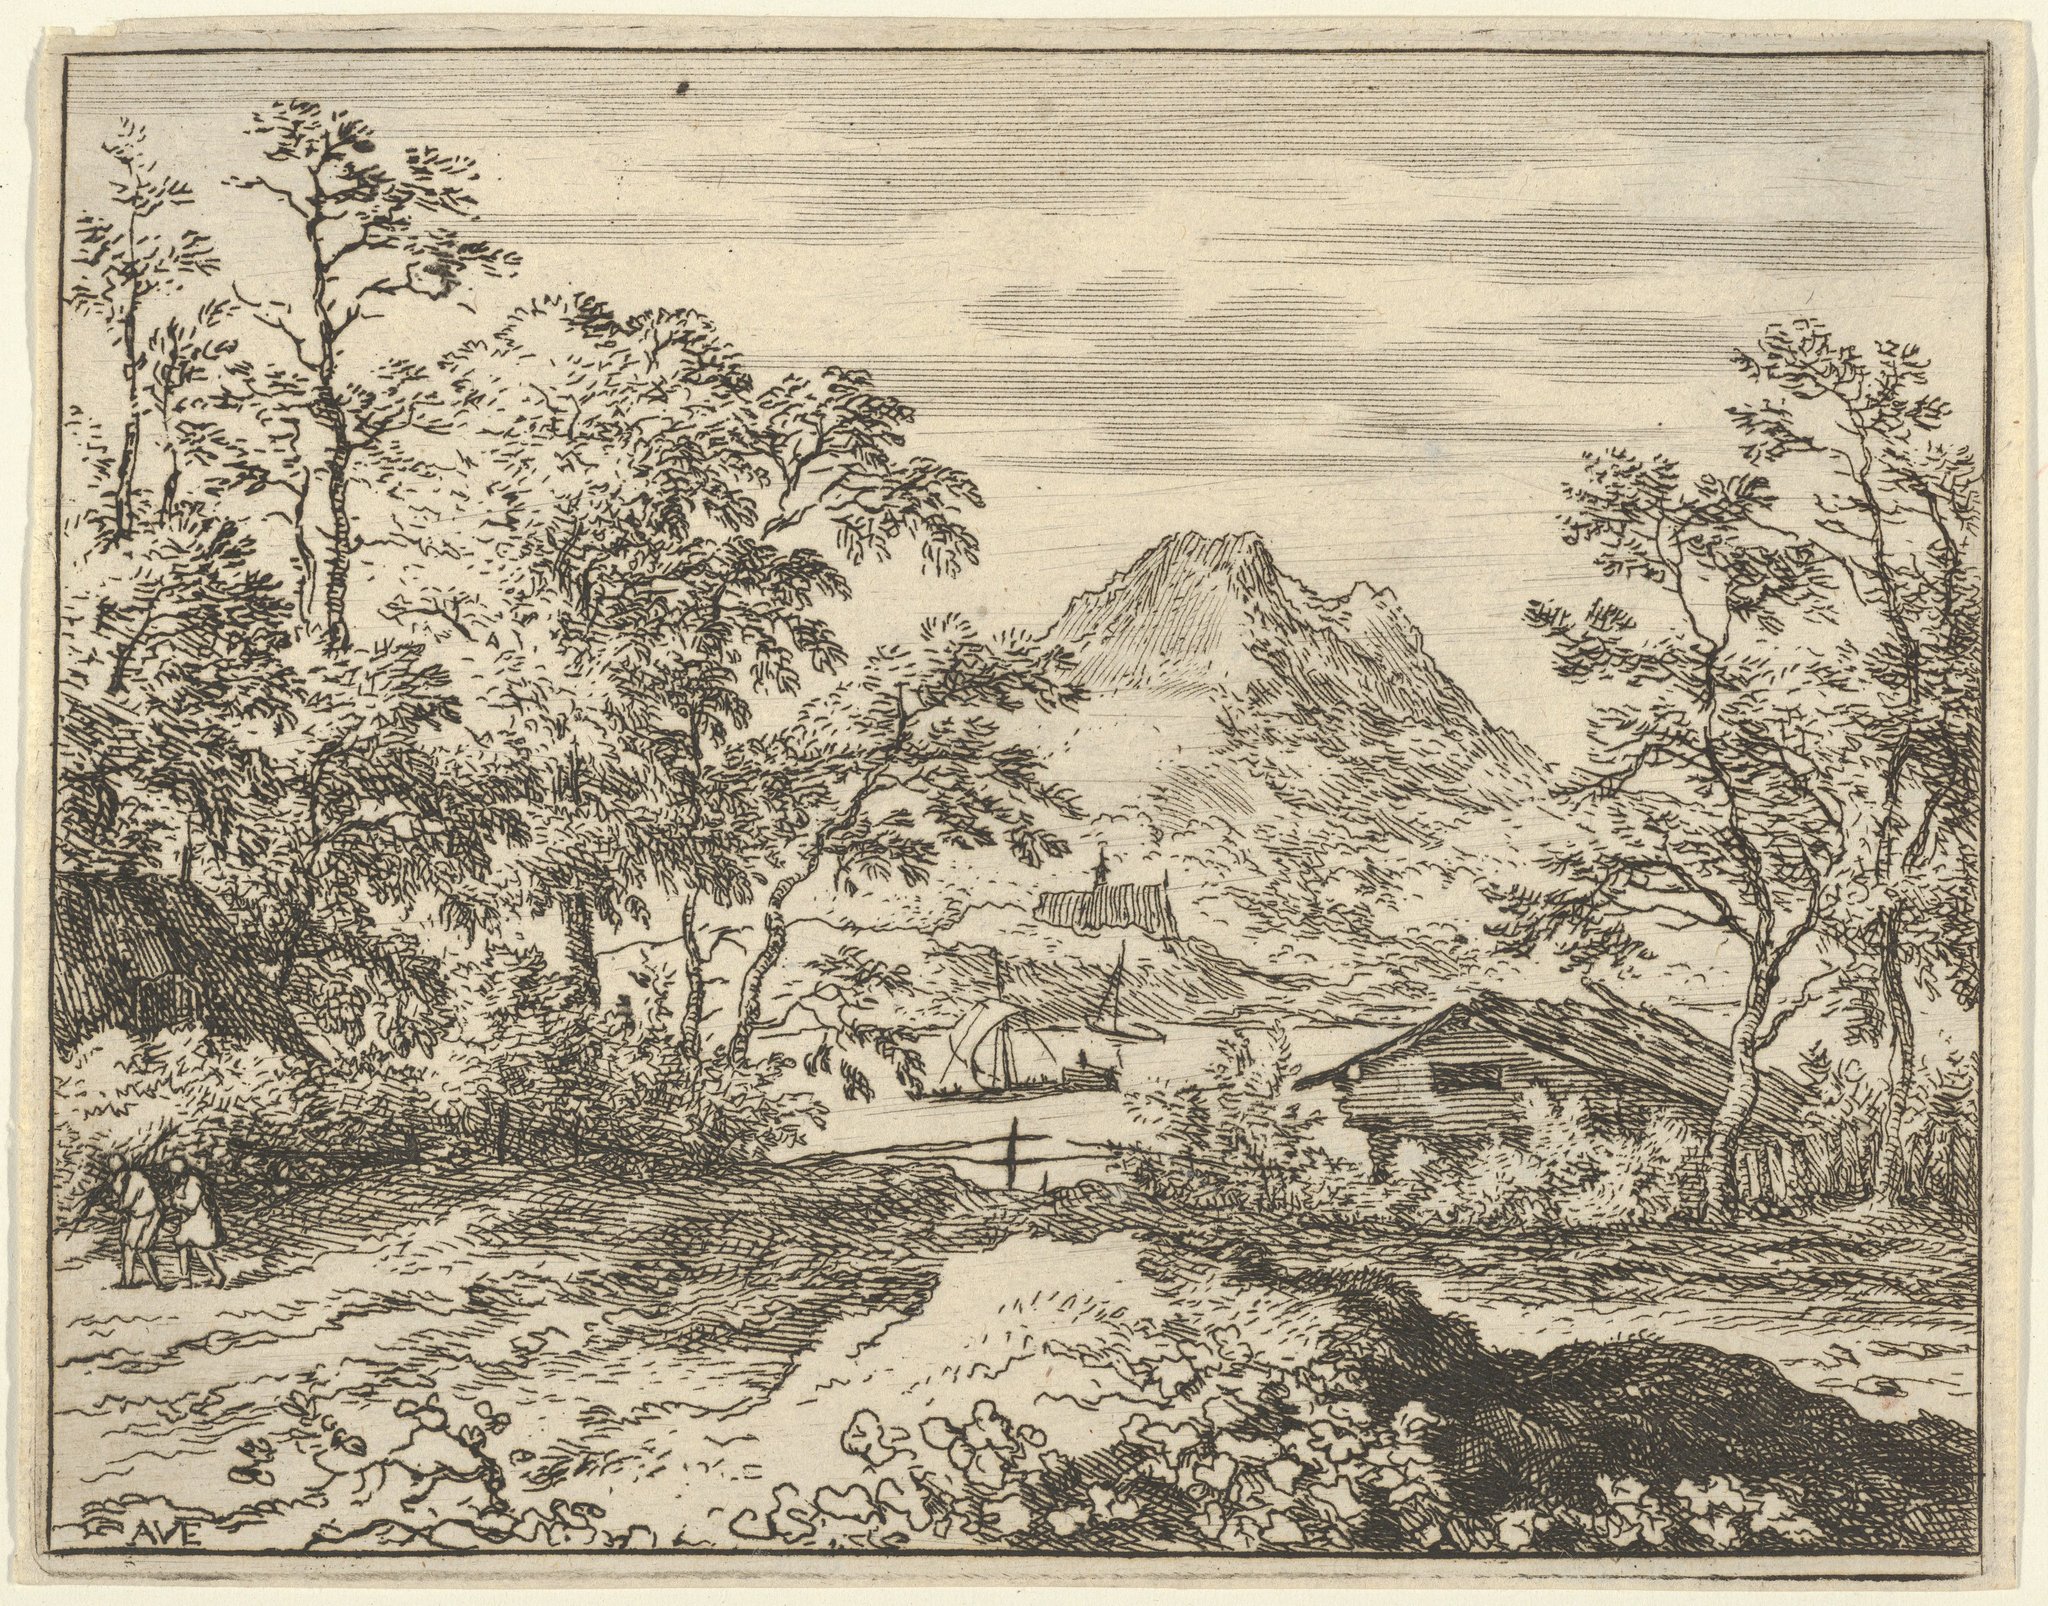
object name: print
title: The Broad River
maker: allart van everdingen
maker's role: artist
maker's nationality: dutch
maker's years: 1621-1675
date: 1621-1675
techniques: engraving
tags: houses,rivers,mountains,trees